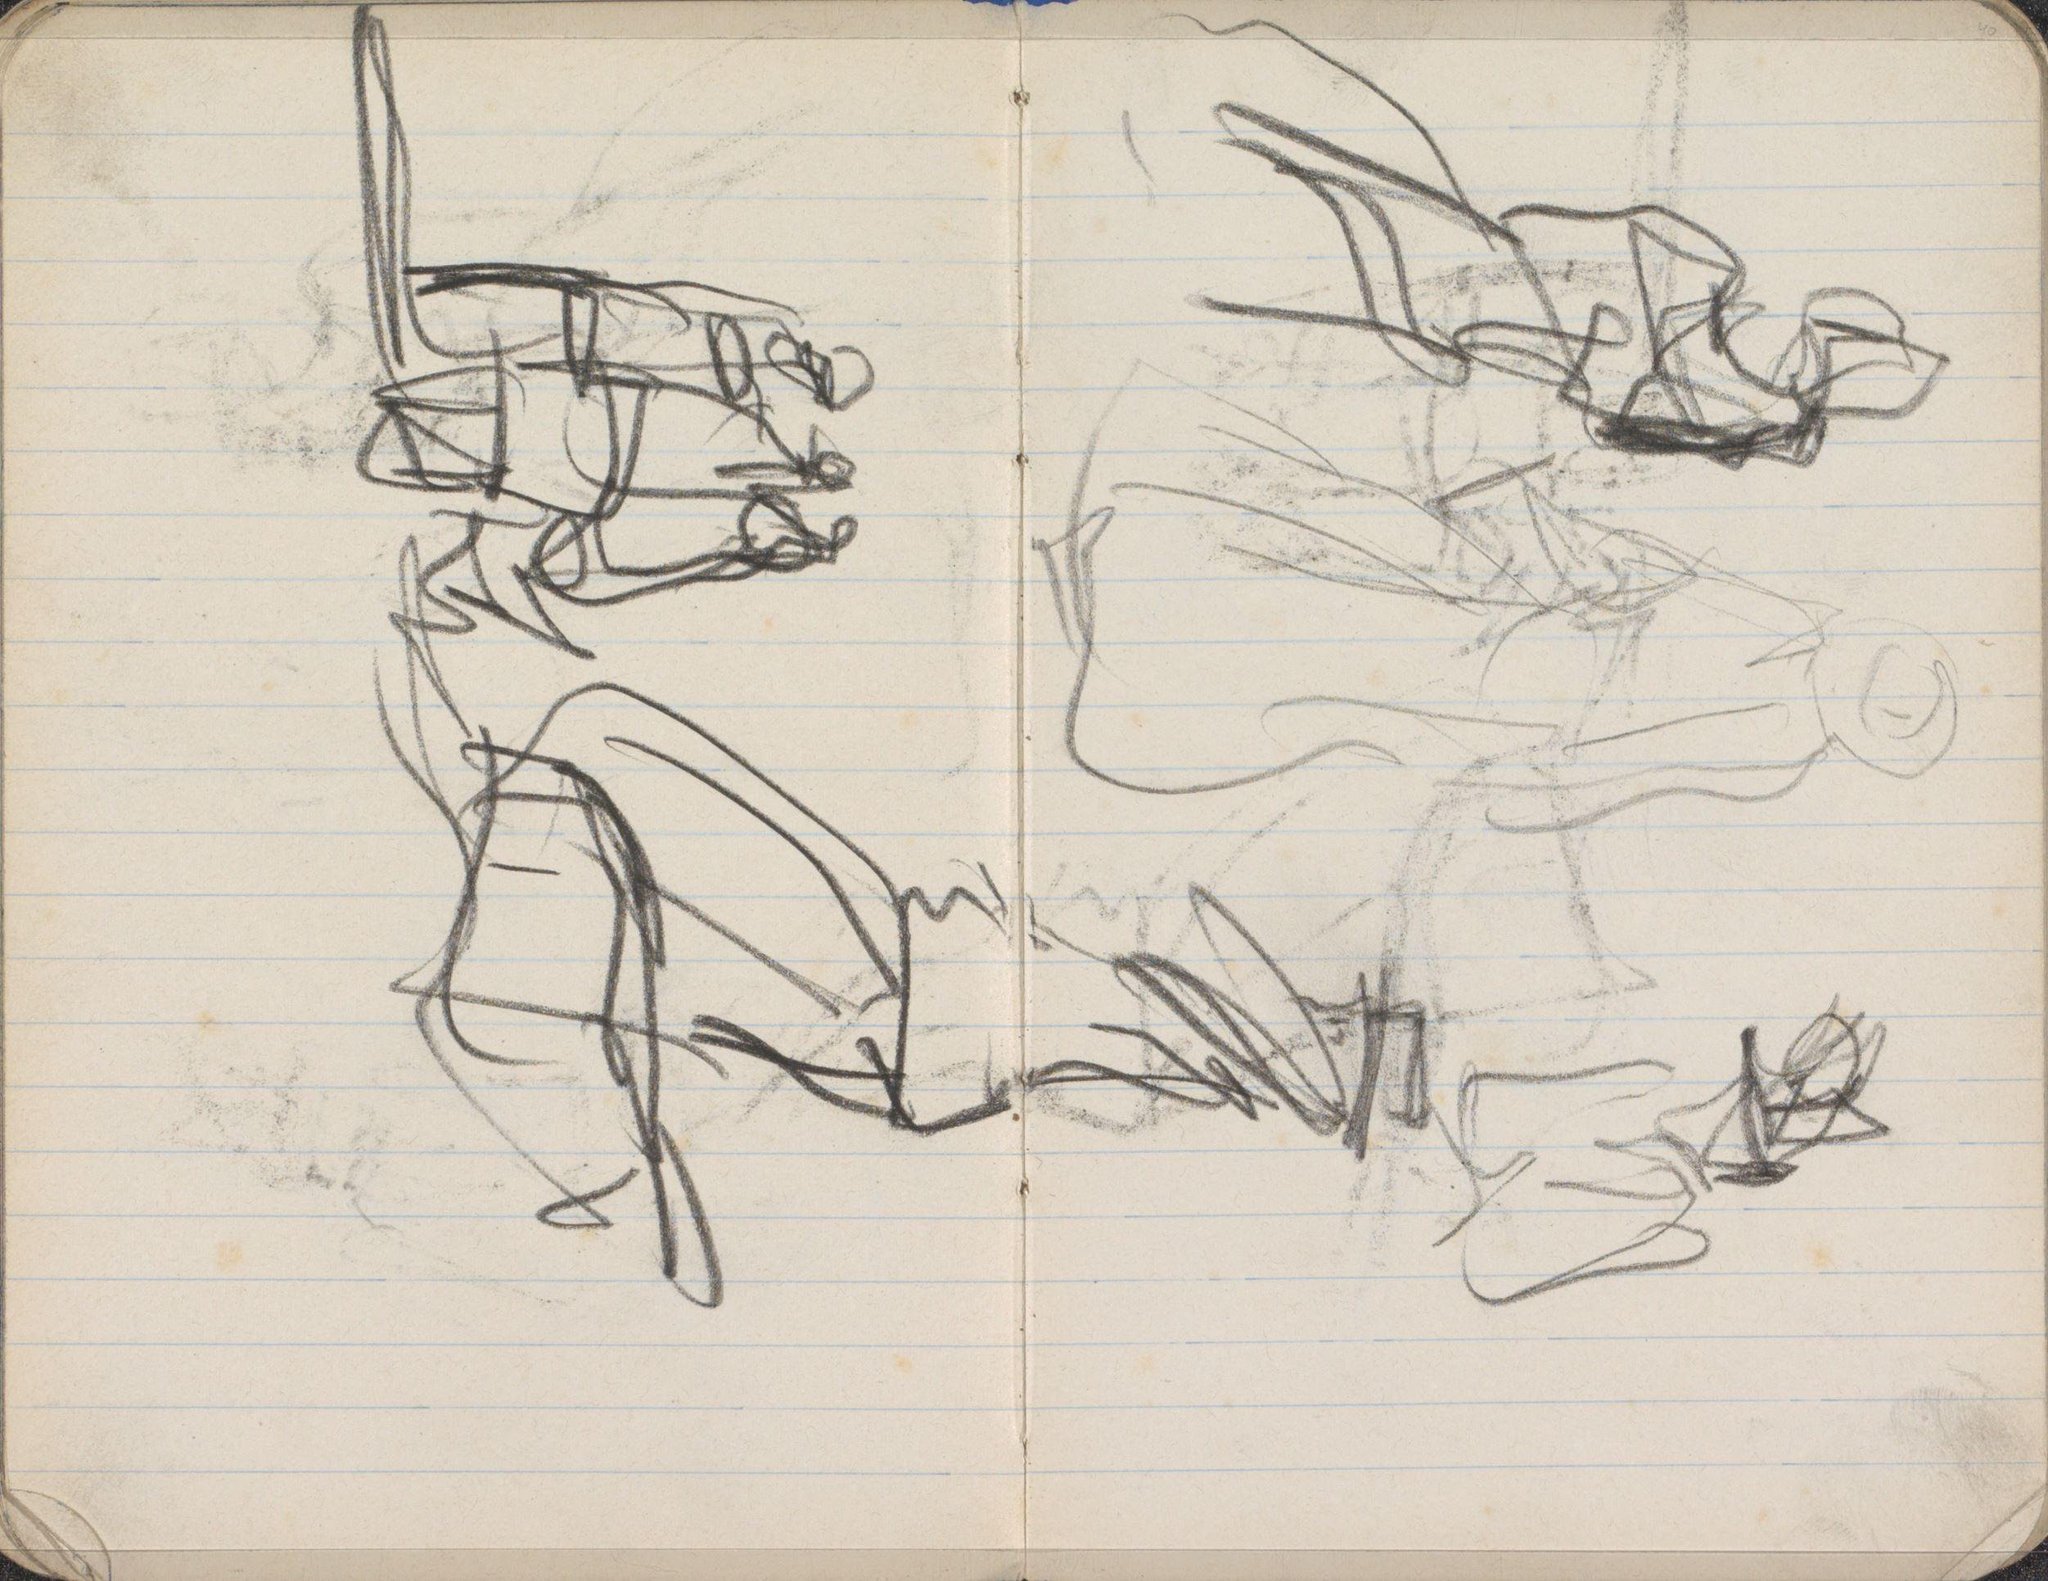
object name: sketchbook leaf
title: Figuurstudies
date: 1898-1902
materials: chalk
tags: adult woman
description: Waarschijnlijk alleen vrouwen. Pagina 39 en pagina 40 uit een schetsboek met 42 bladen.